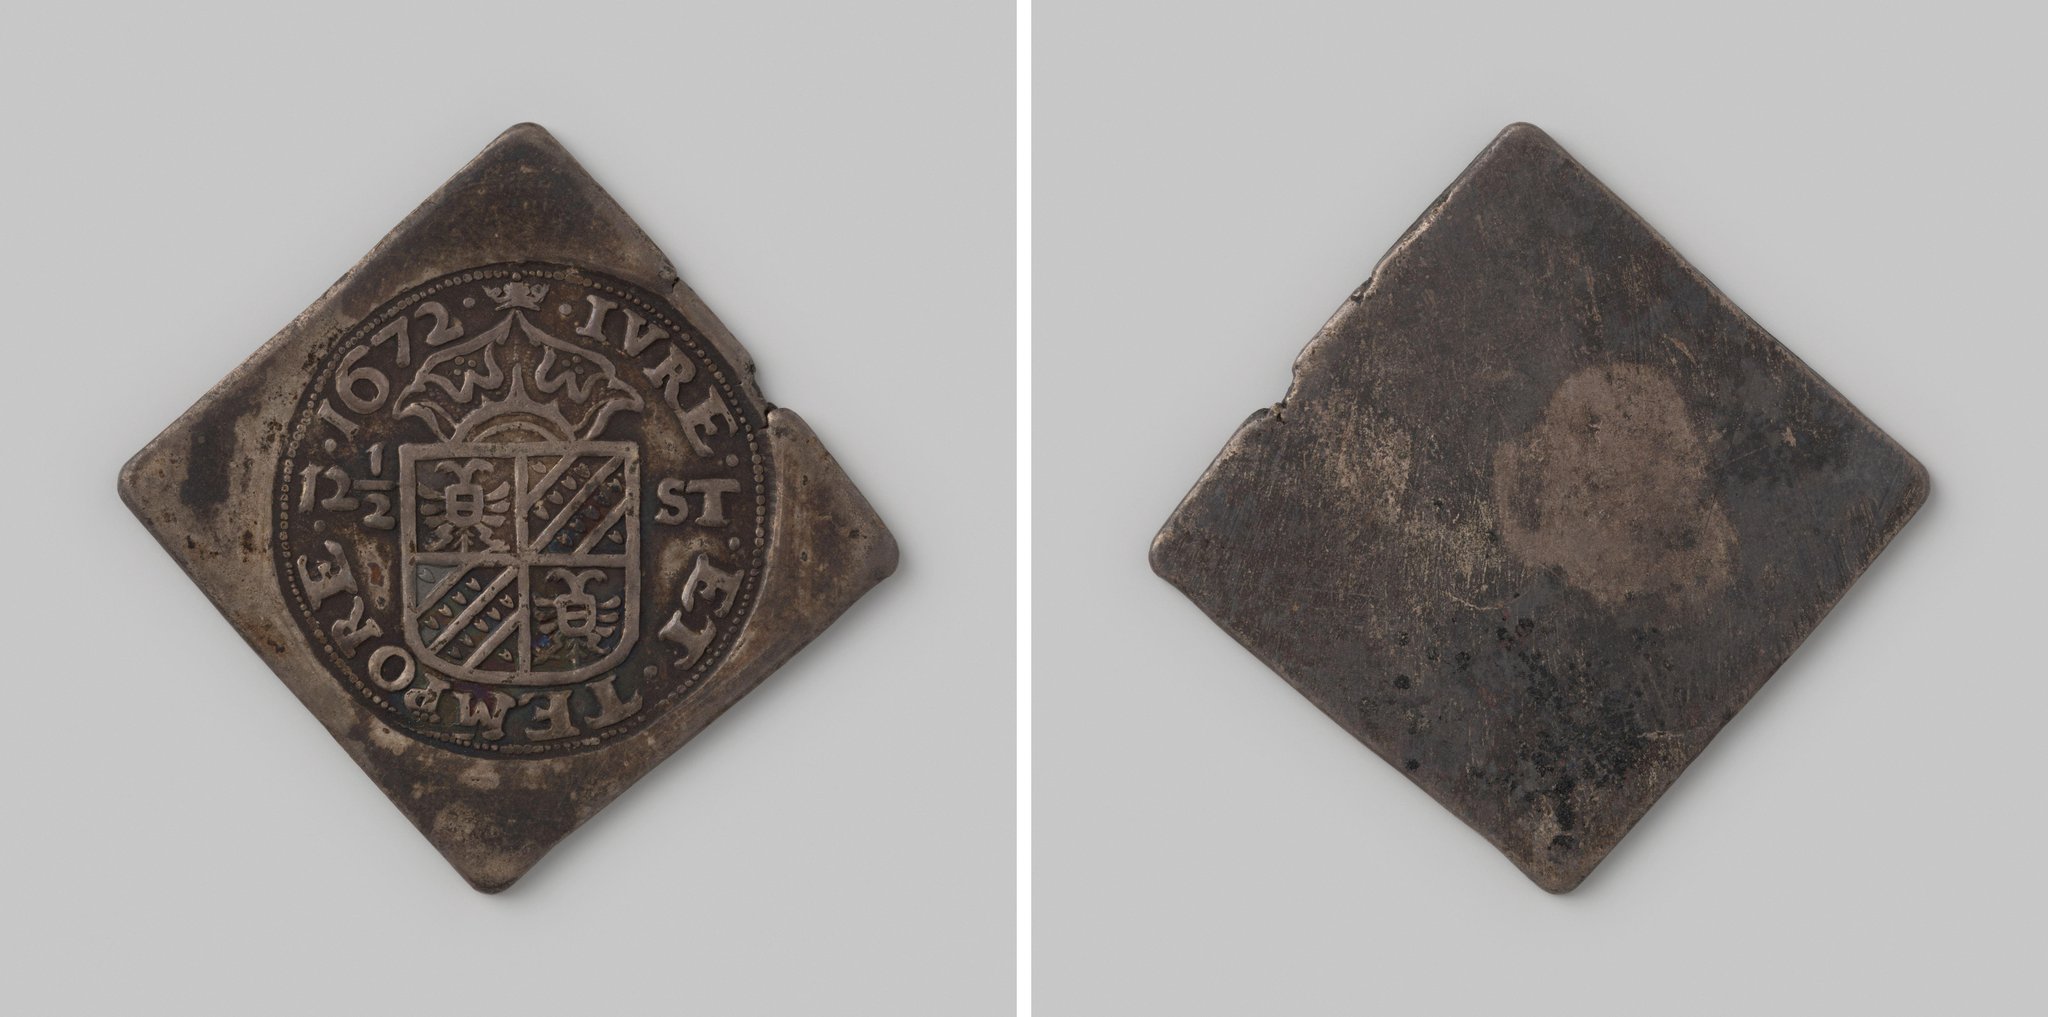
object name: coin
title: Stad Groningen, herdenkingsmunt van 12½ stuiver, 1672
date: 1672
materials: silver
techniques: striking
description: Zilveren vierkante herdenkingsmunt. Voorzijde: tussen waarde-aanduiding: 12½ ST gekroond samengesteld wapenschild van de stad en de Ommelanden. Jaartal in omschrift linksboven. Keerzijde: glad.